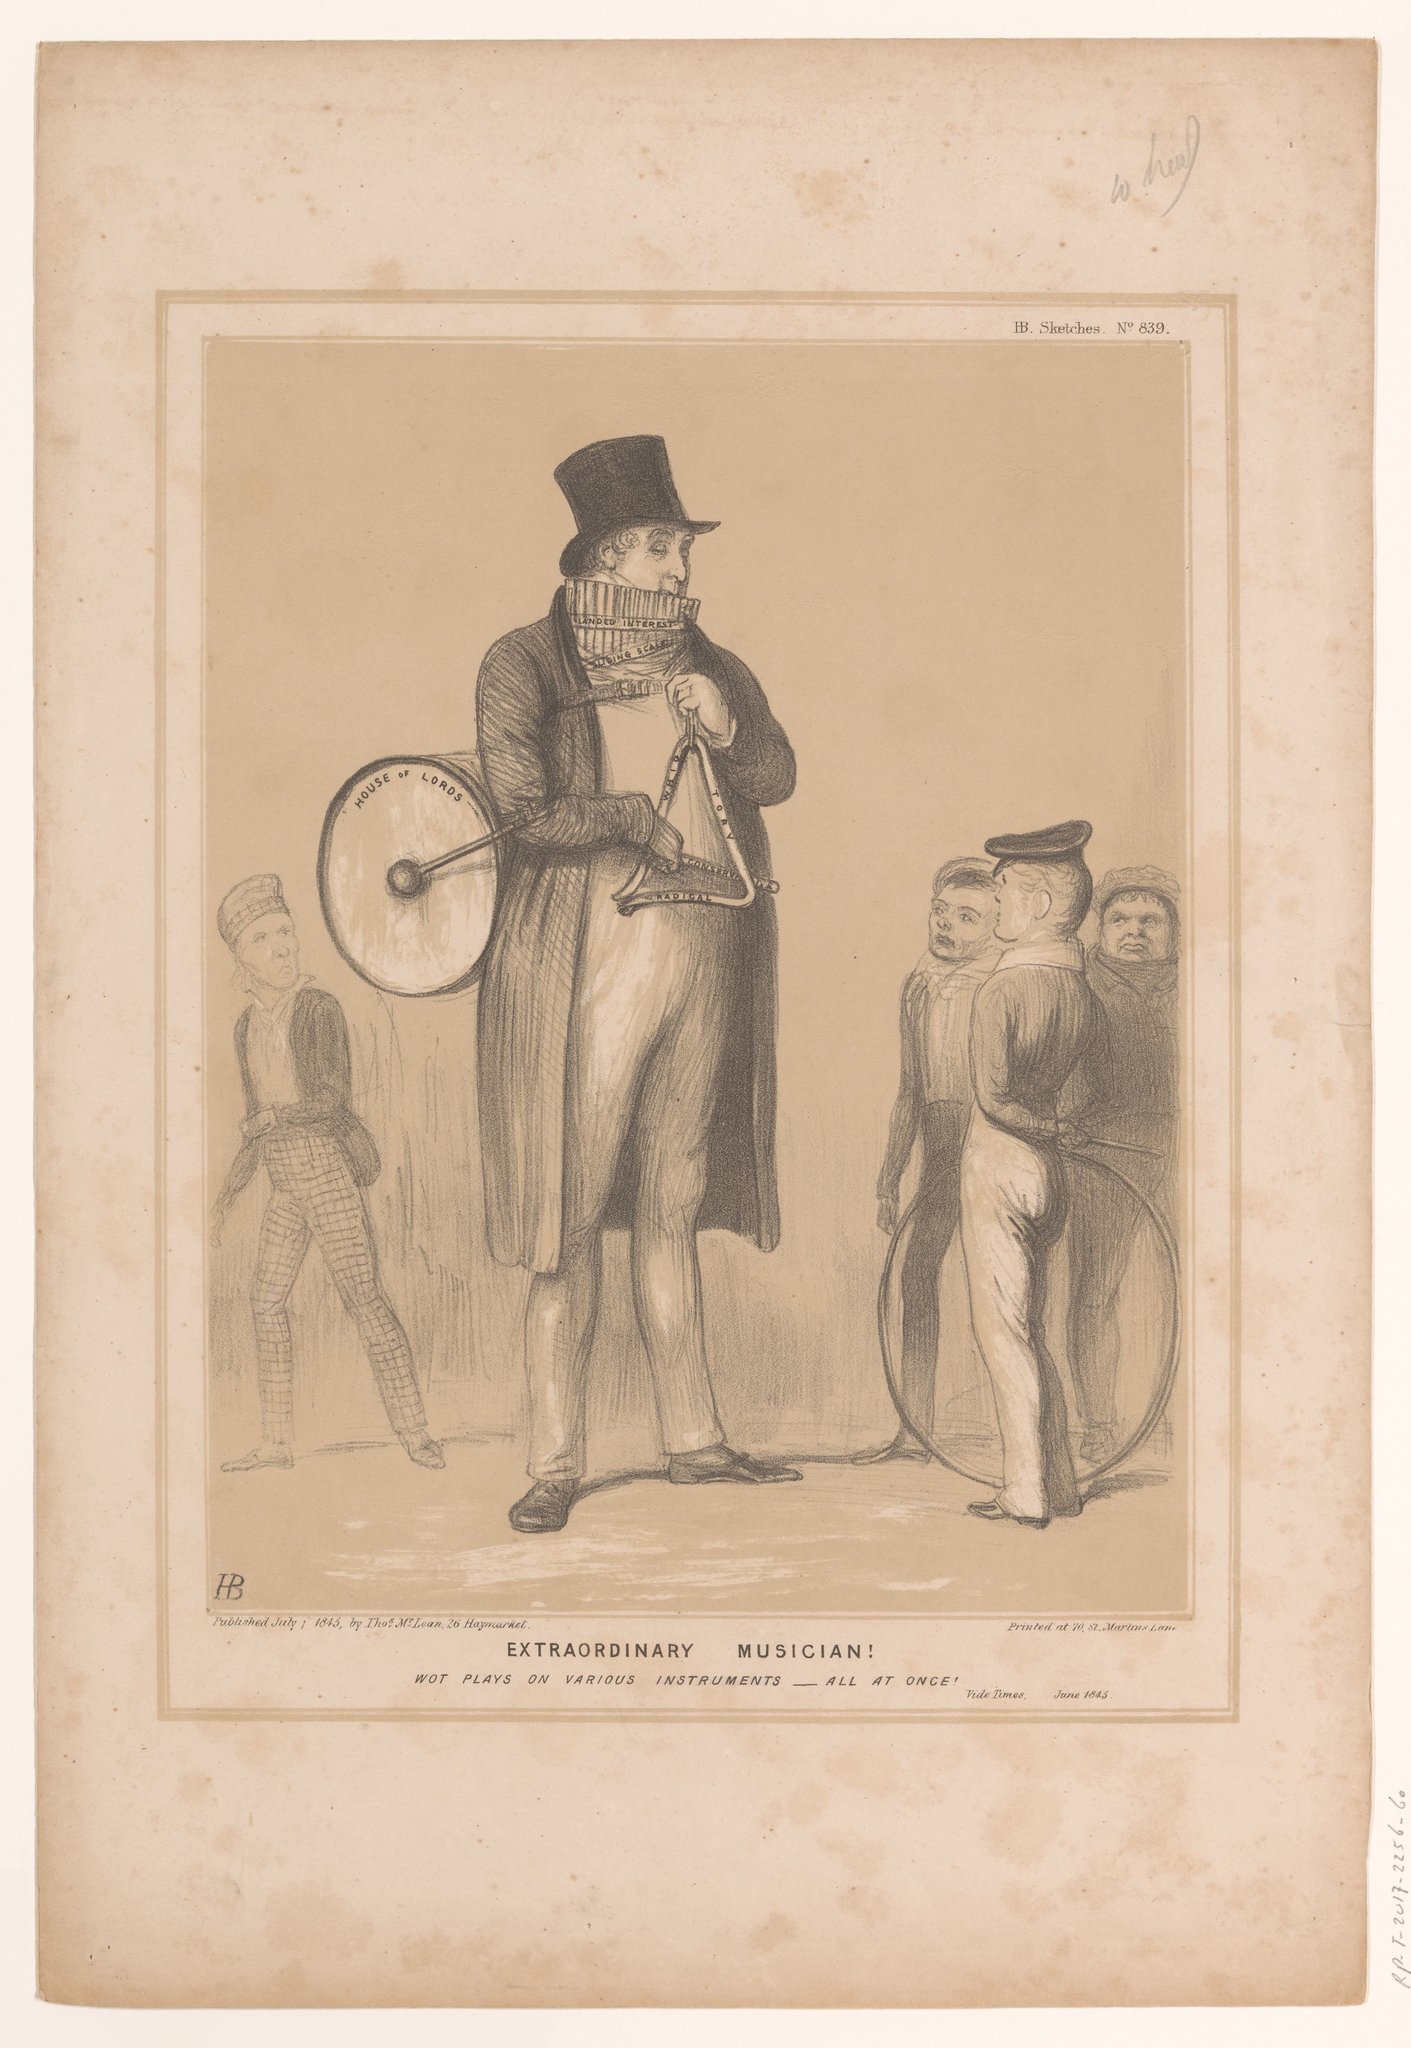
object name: print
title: HB Sketches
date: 1845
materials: paper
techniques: tone lithography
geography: london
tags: london, political caricatures and satires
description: Spotprent uit 1845 met premier Robert Peel als eenmansorkest spelend op straat, omgeven door straatjongens. Uitgegeven als nr. 839 in de serie HB Sketches.